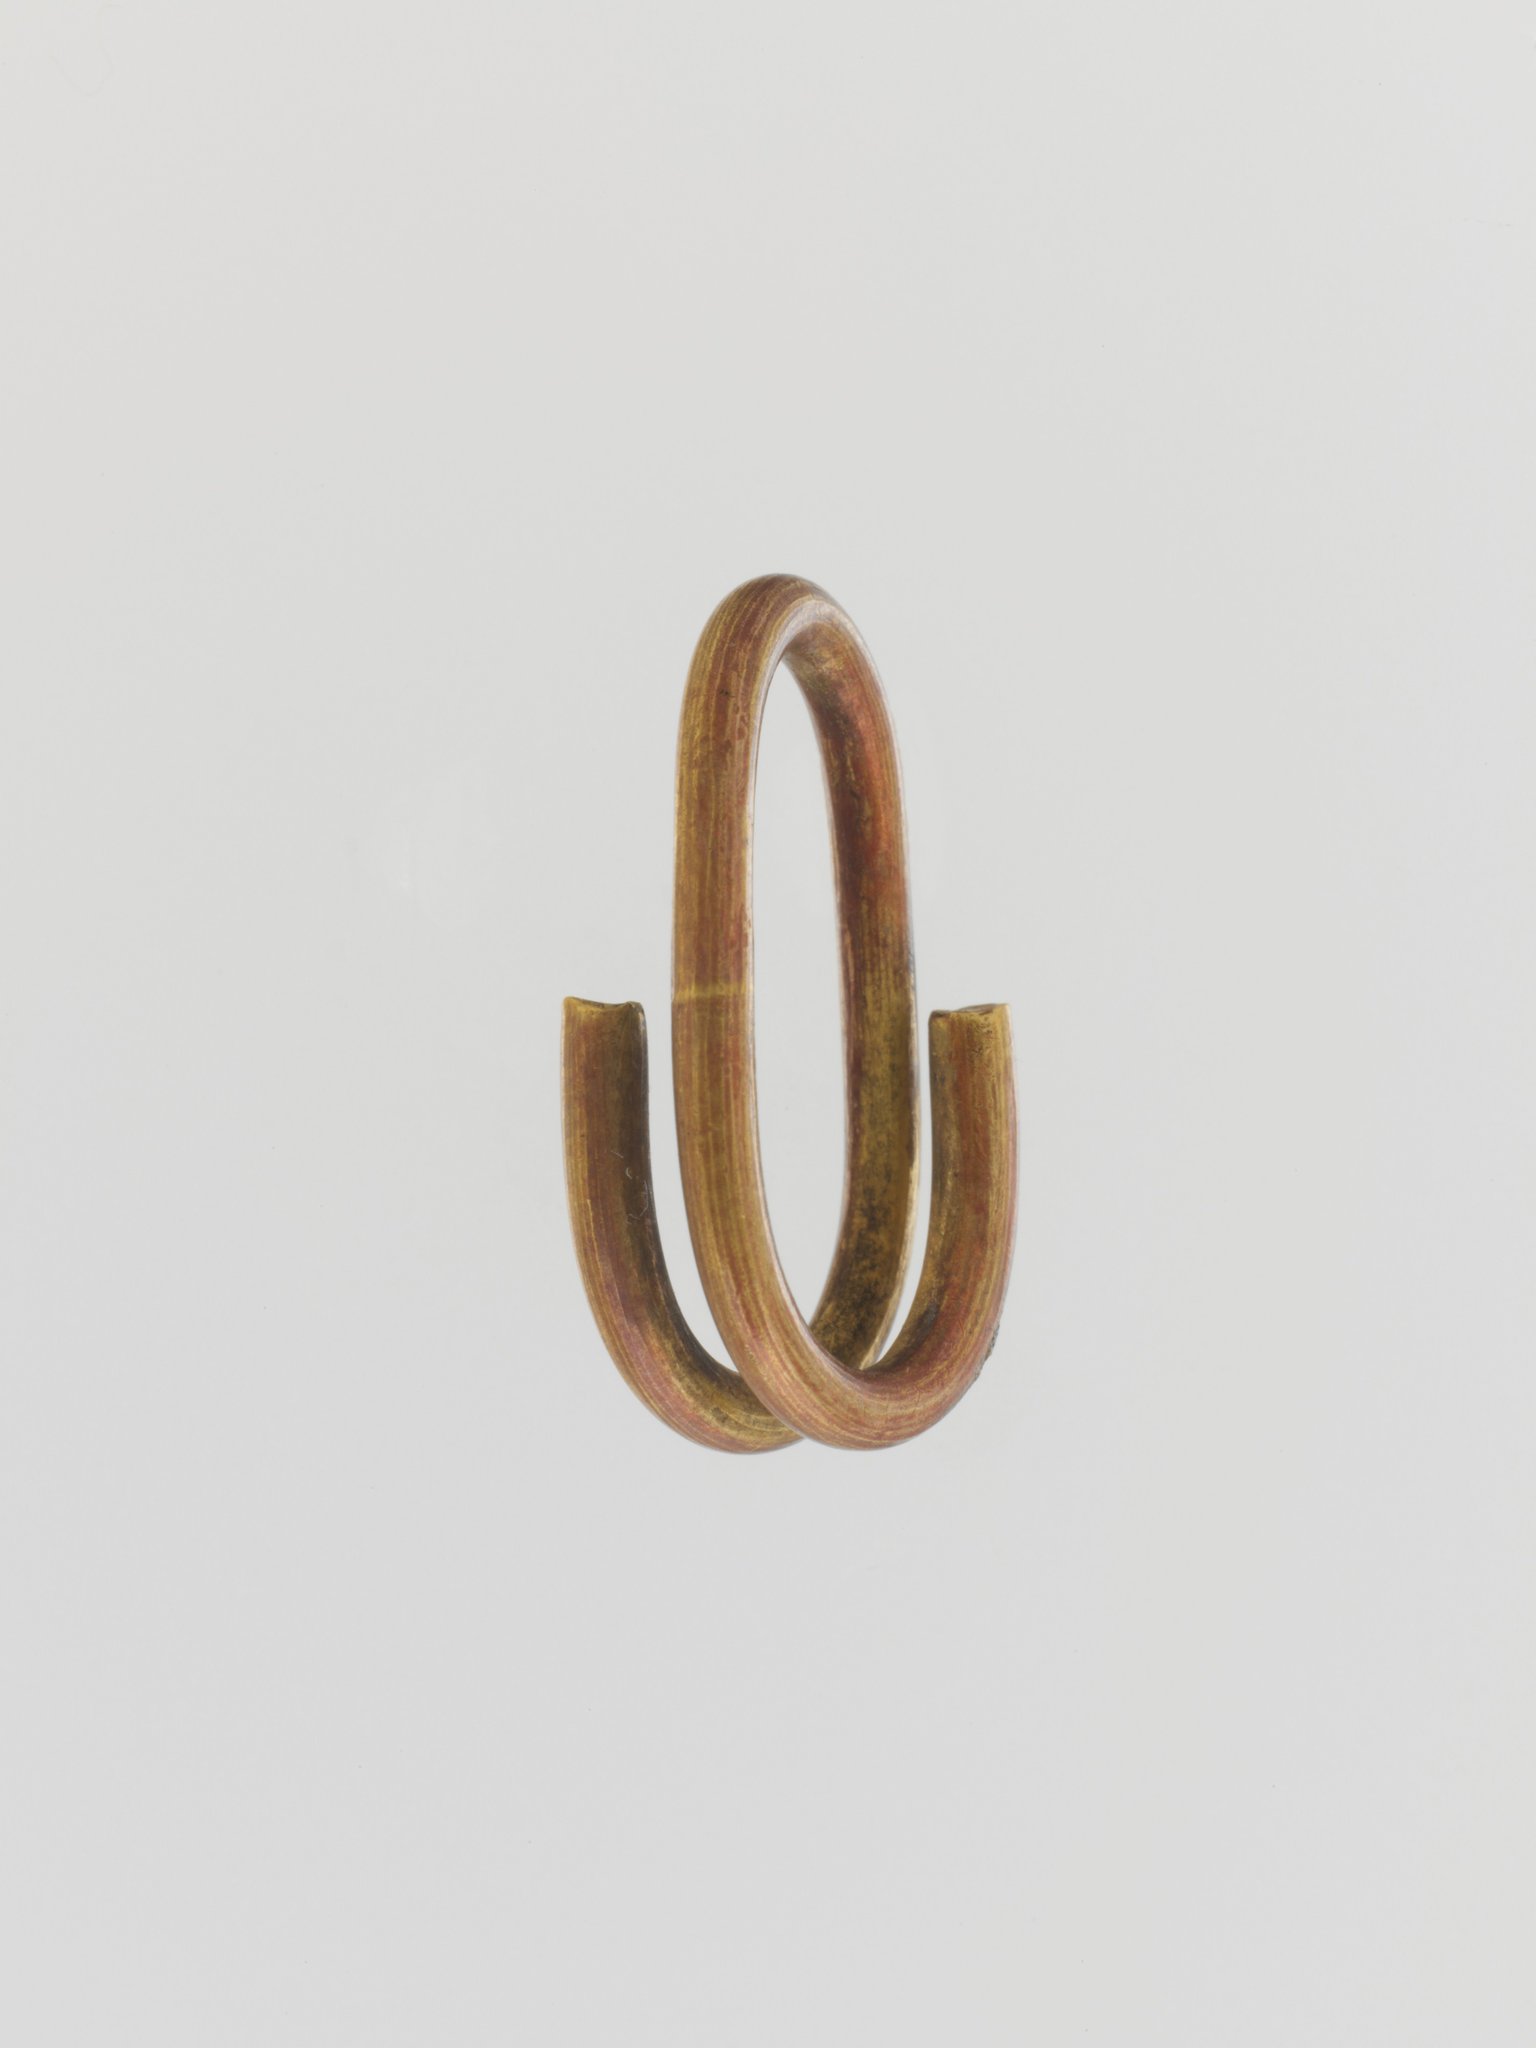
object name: earring or spiral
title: Gold spiral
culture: cypriot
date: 1600-1100 BCE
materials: gold